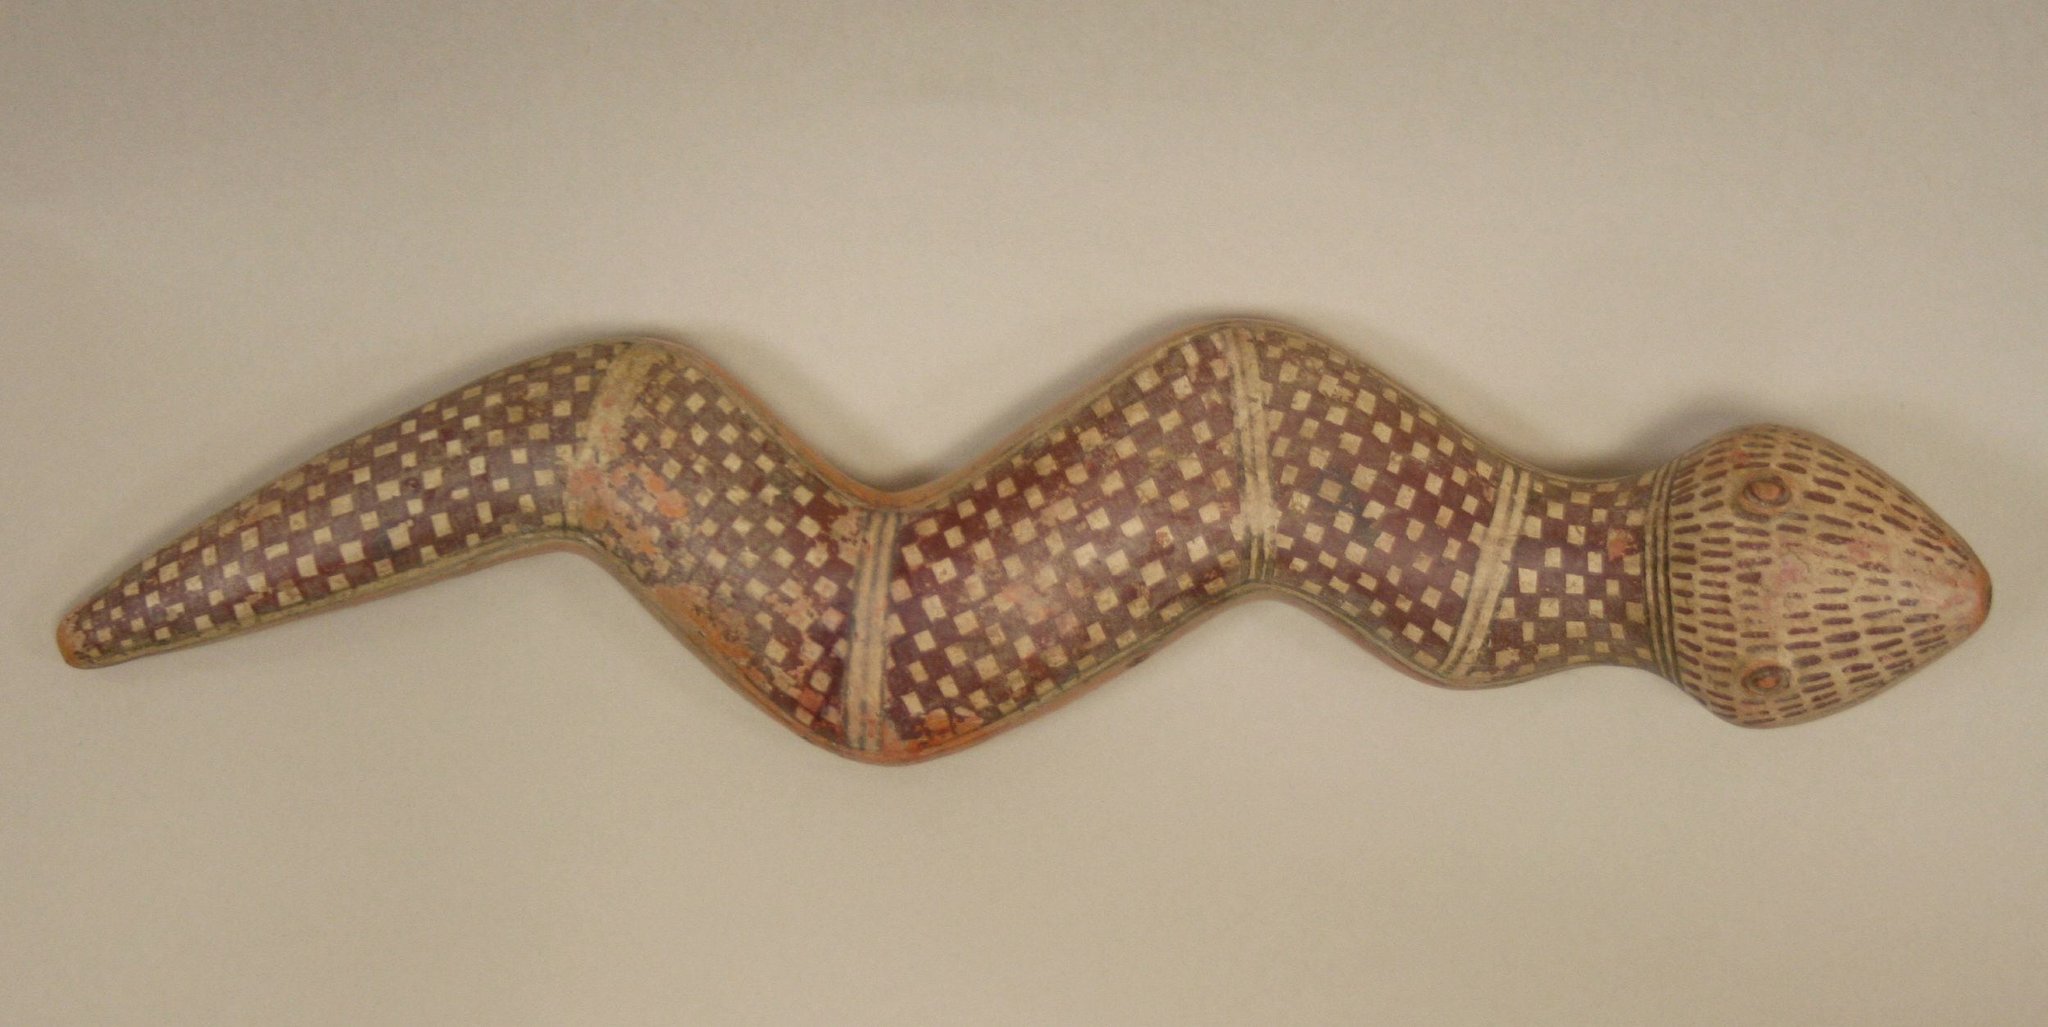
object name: paccha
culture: inca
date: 1401-1600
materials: ceramic, pigment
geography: peru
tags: snakes